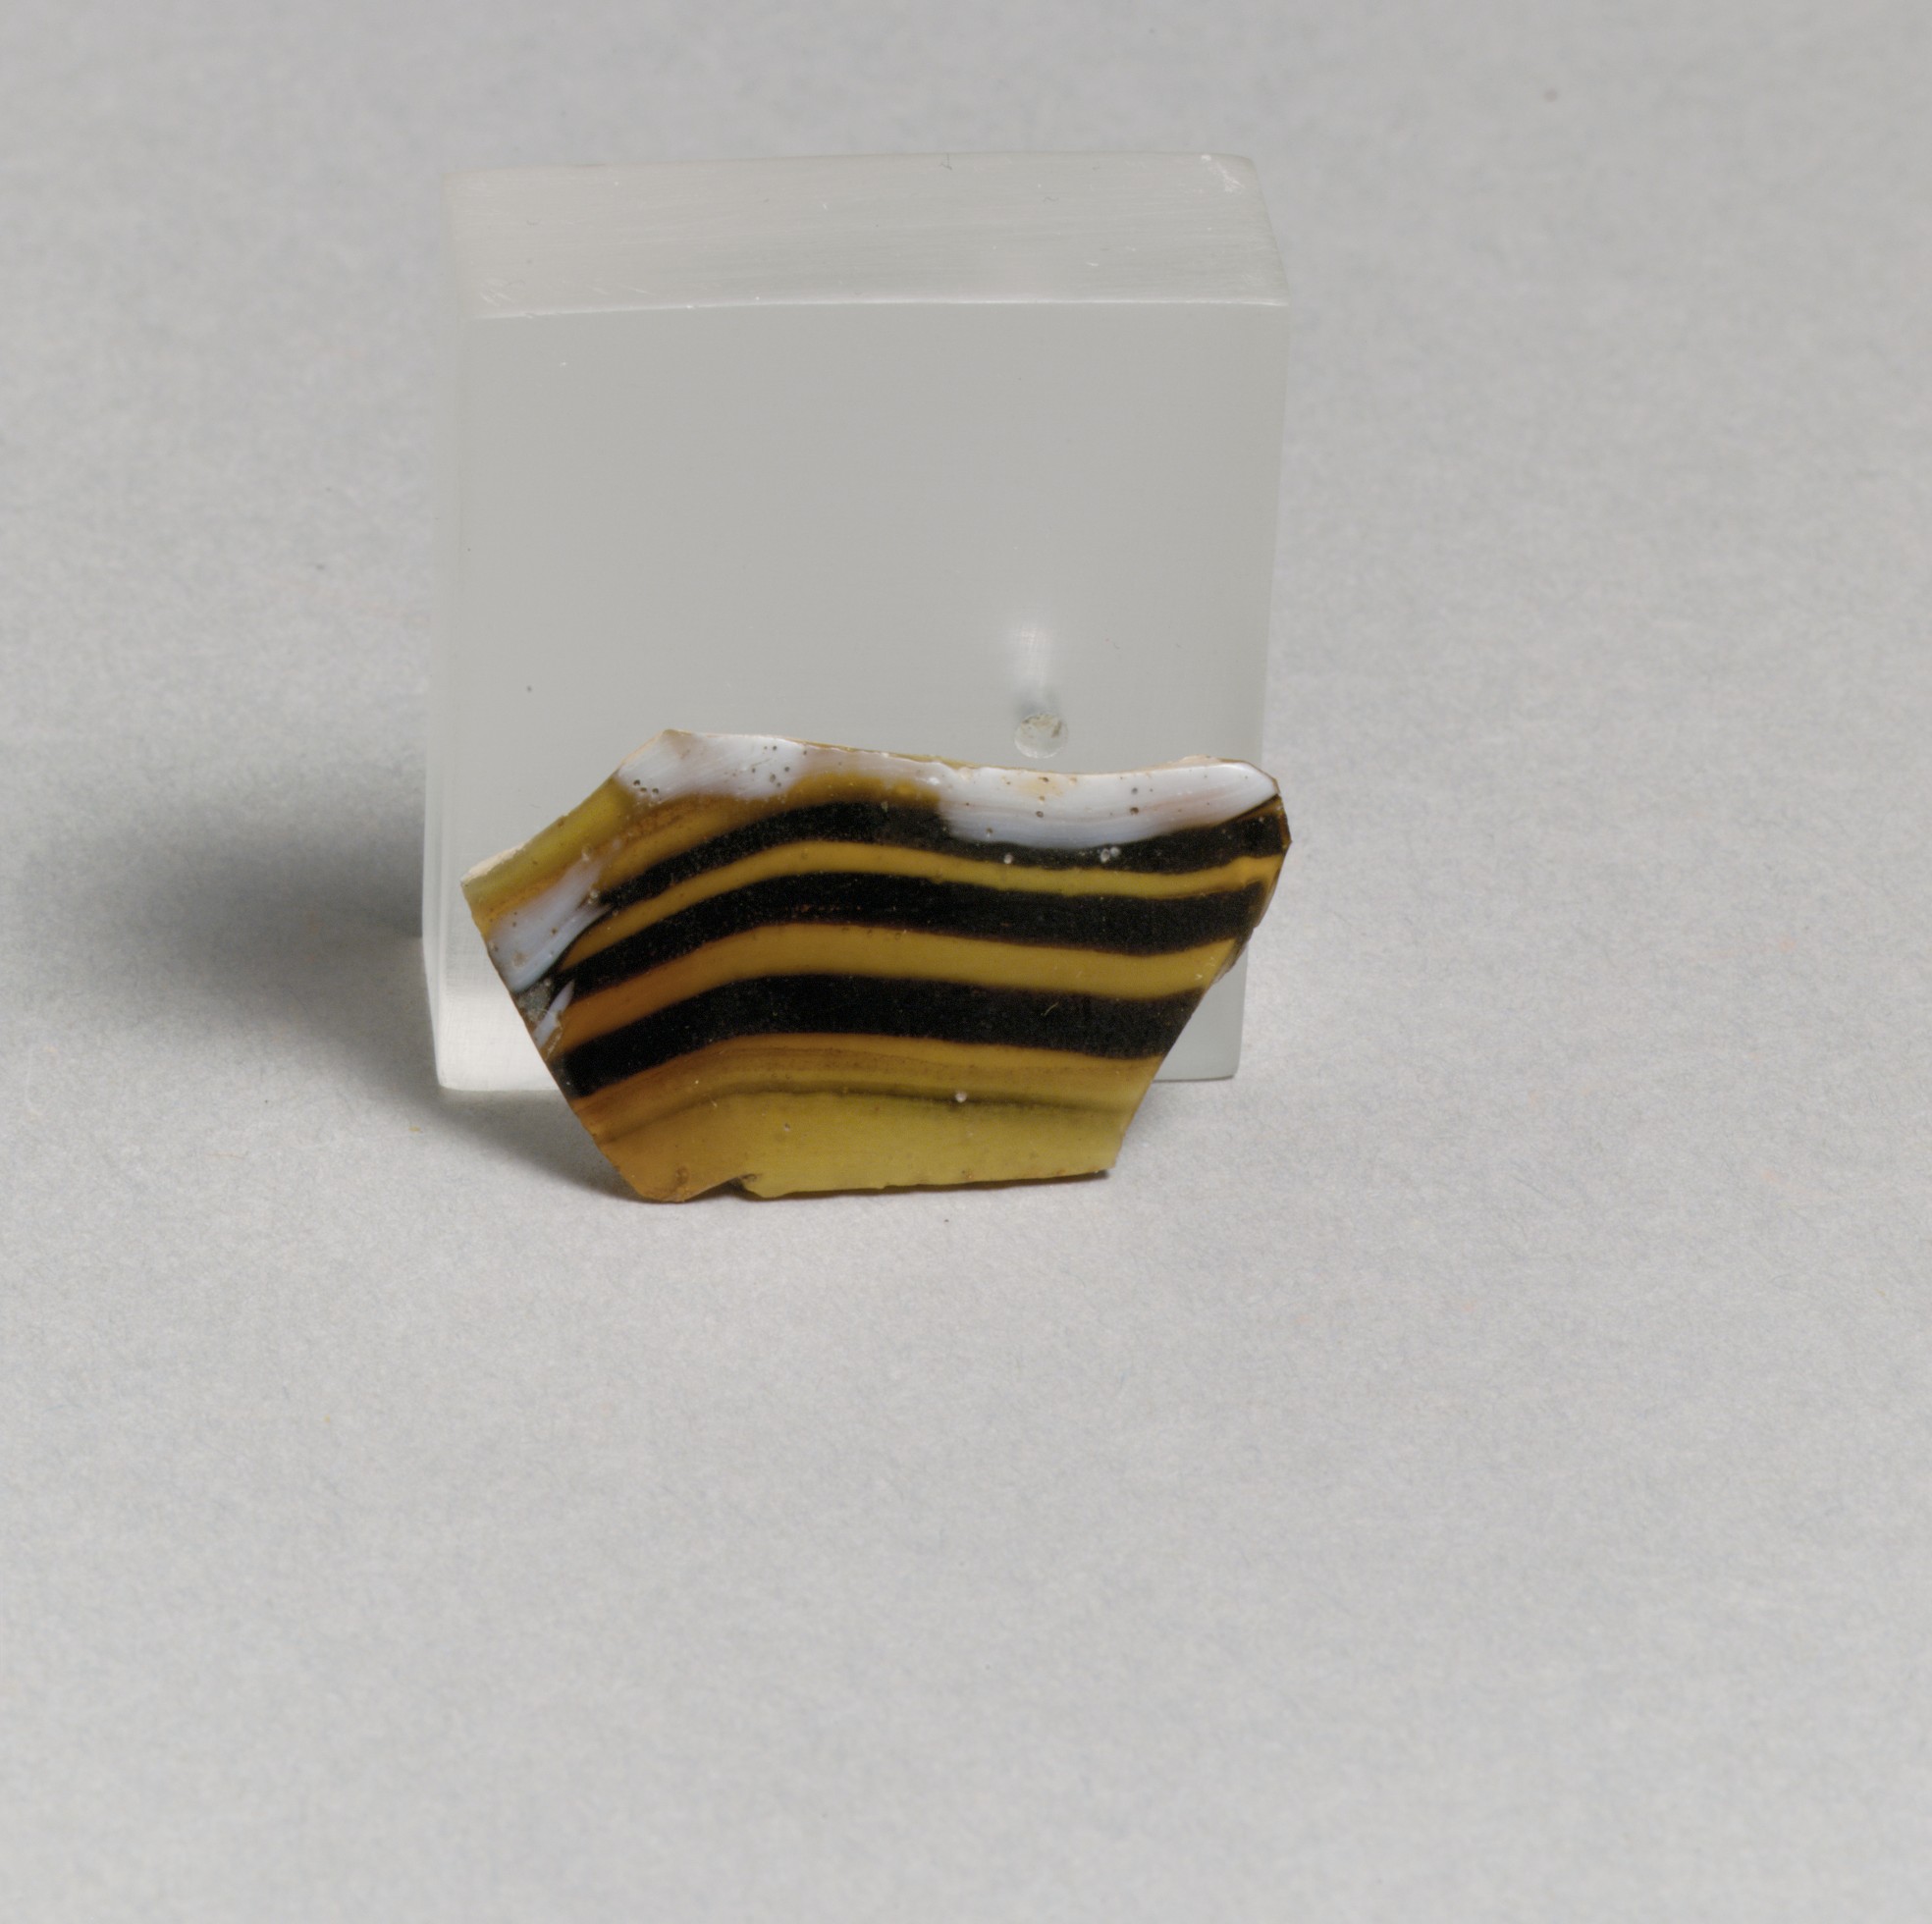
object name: fragment, striped mosaic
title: Glass mosaic fragment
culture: roman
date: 34 BCE-33 CE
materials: glass